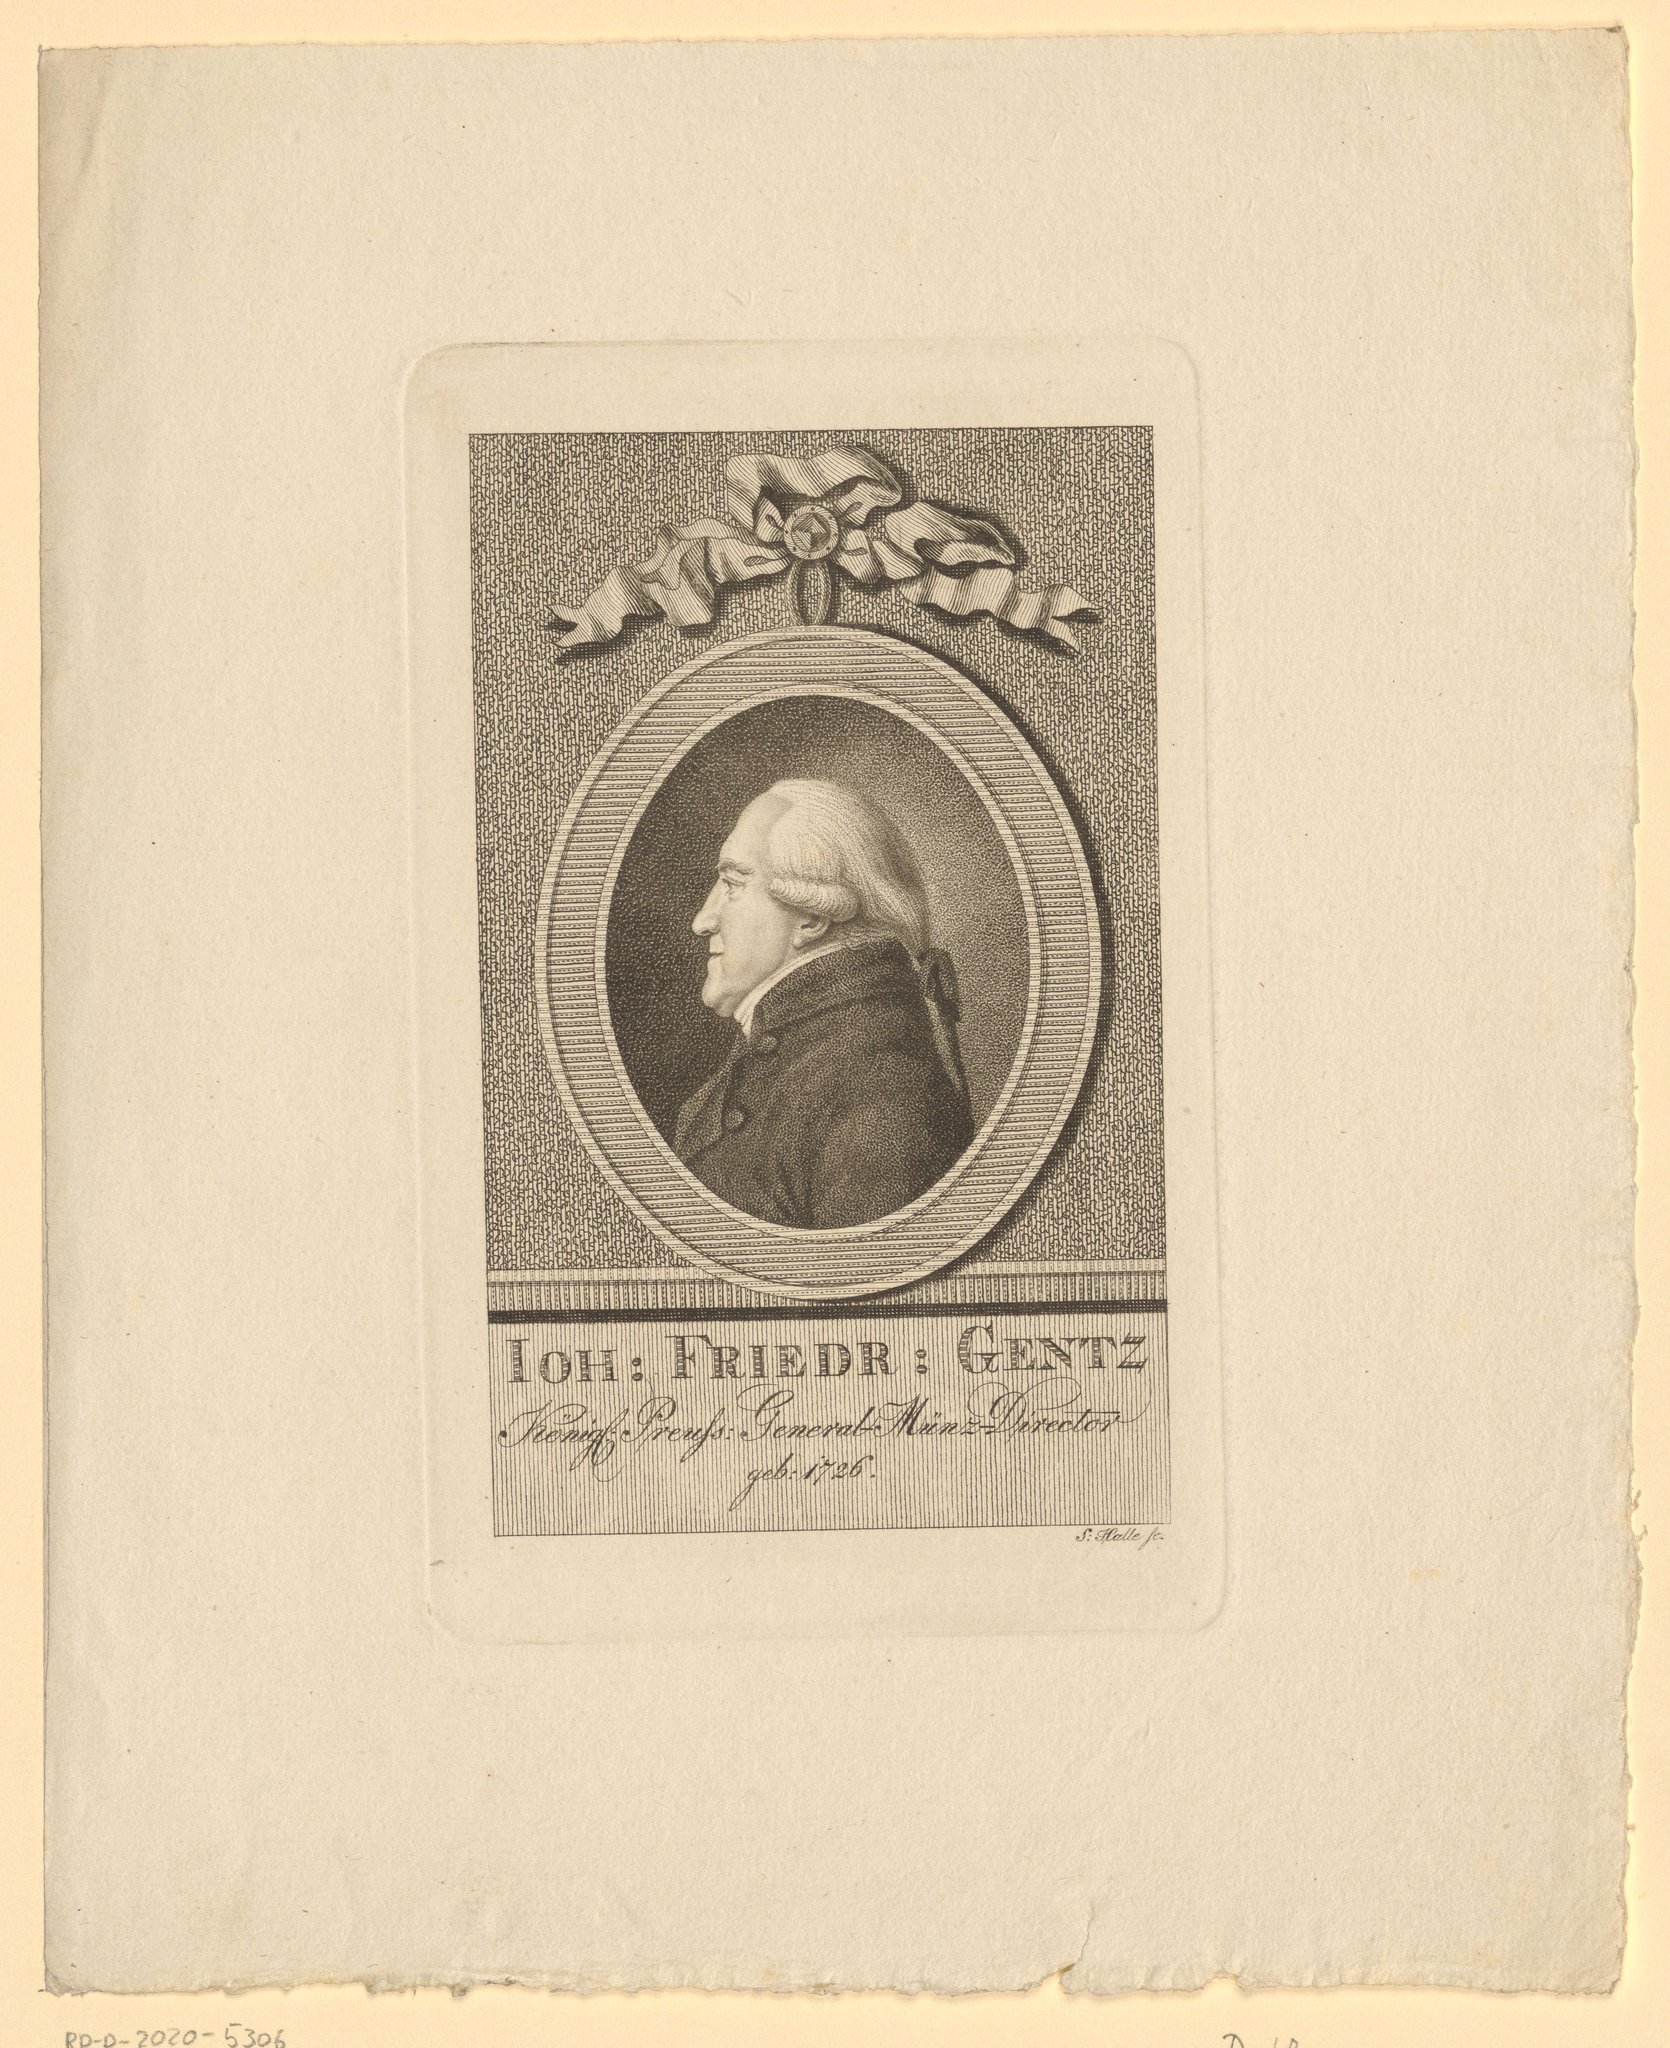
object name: print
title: Portret van Johann Friedrich Gentz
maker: johann samuel ludwig halle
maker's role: print maker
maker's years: 1763-1829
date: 1750-1849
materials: paper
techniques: engraving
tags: historical persons